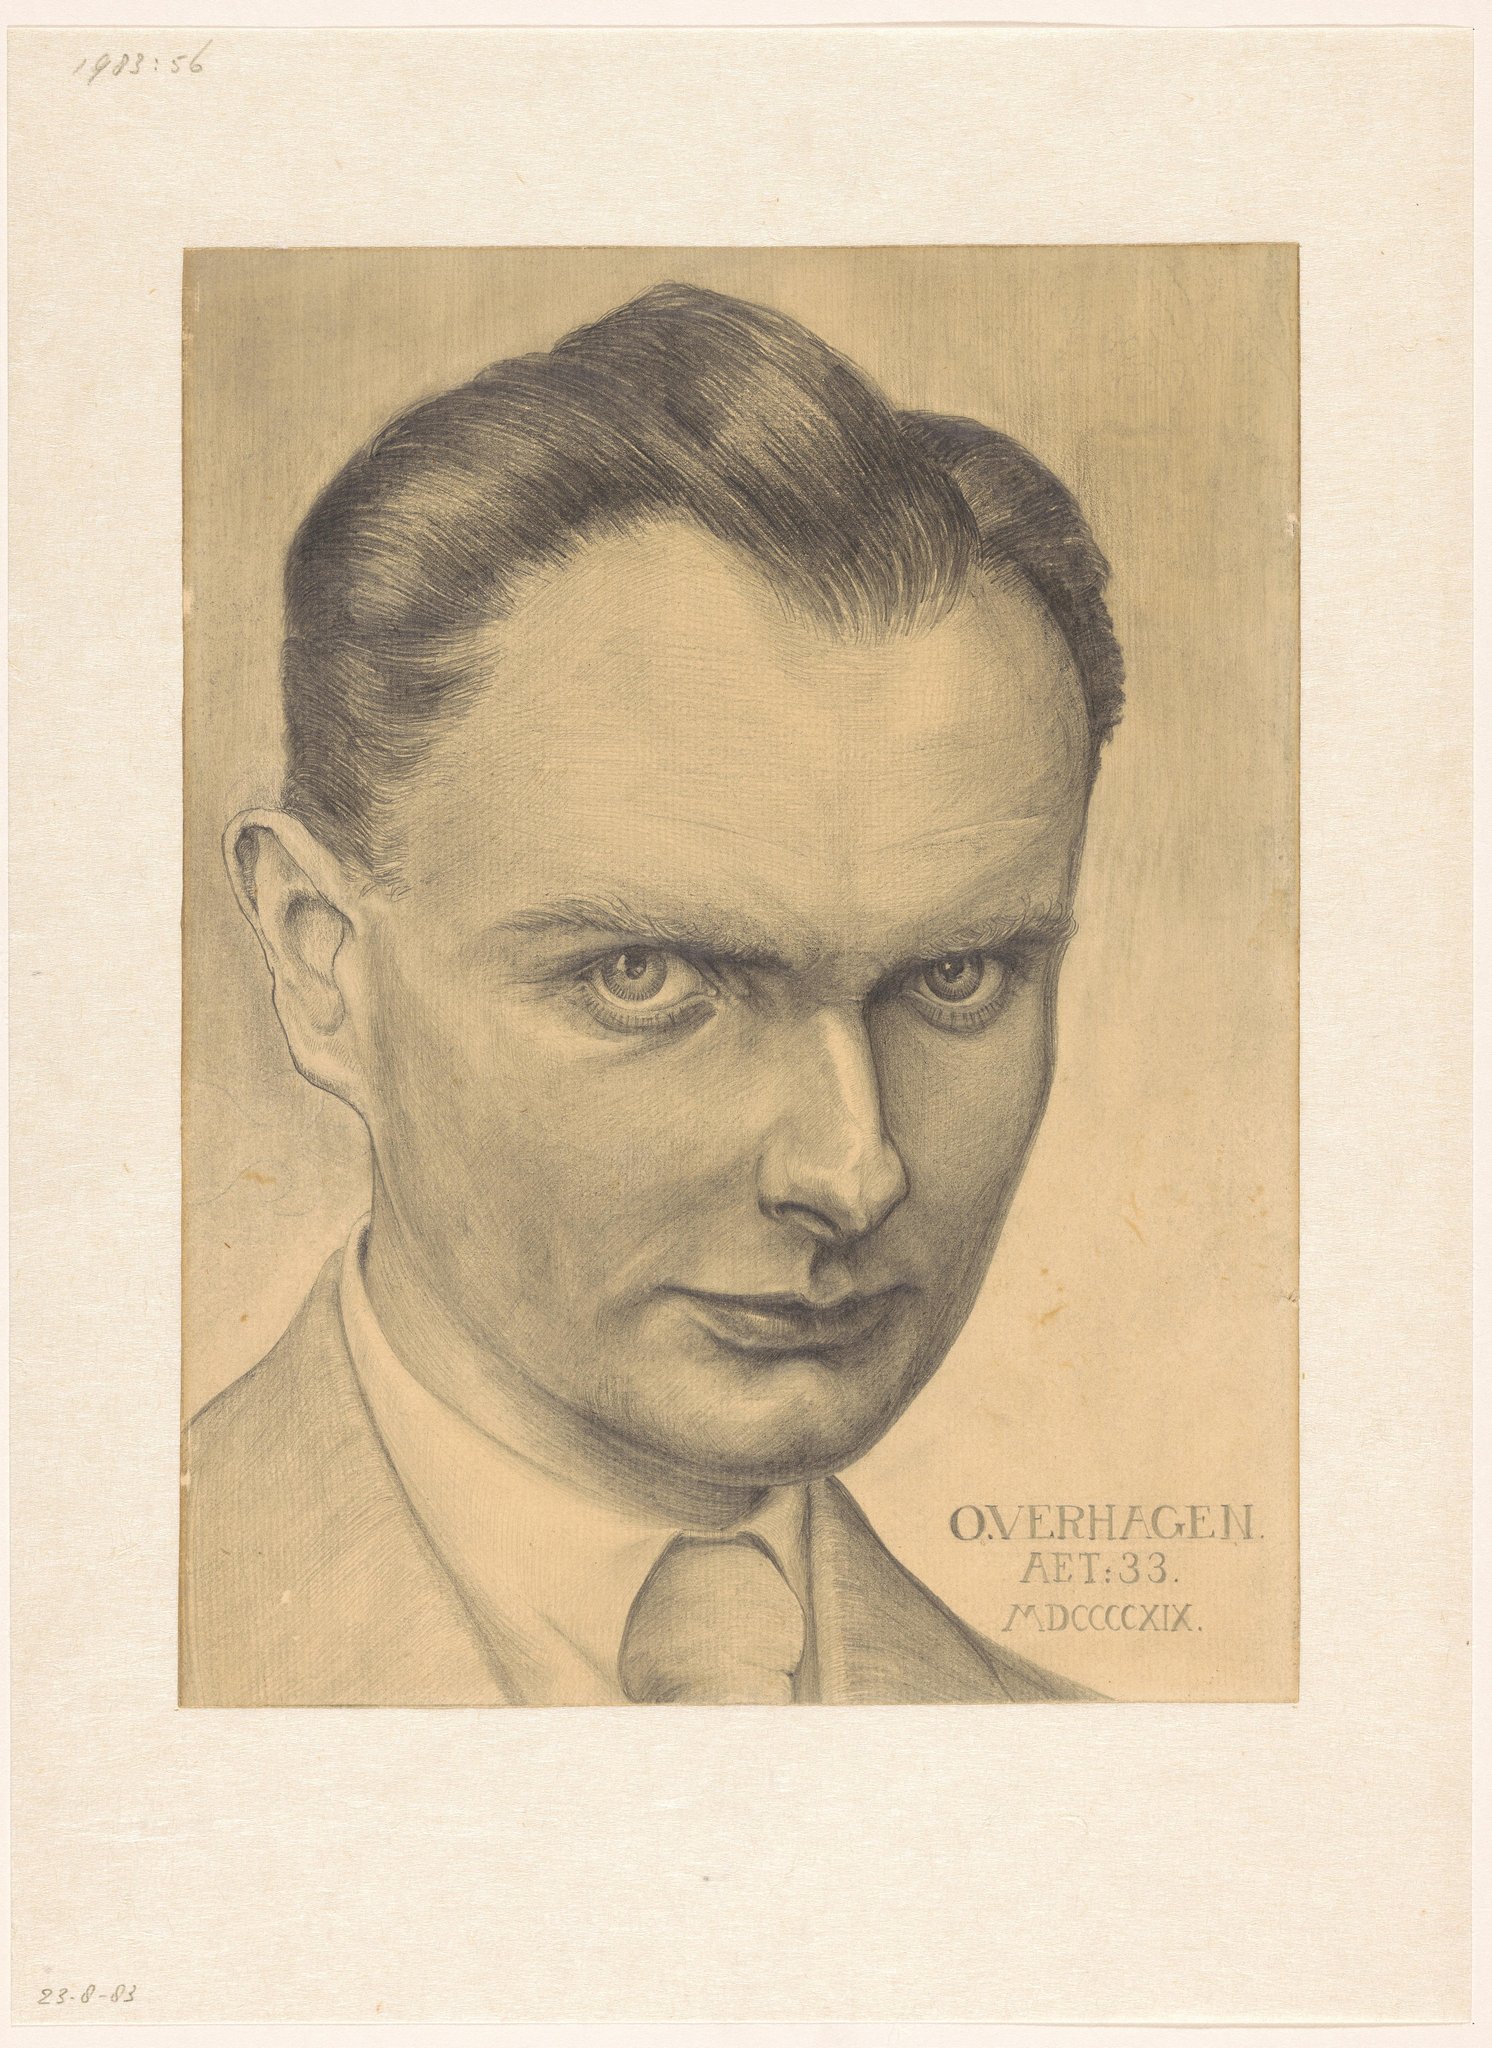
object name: drawing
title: Zelfportret op 33-jarige leeftijd.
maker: otto verhagen (i)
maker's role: draughtsman, print maker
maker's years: 1885-1951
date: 1919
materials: paper, pencil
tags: the hague, print maker, draughtsman, otto verhagen (i), historical persons, portrait, self-portrait of artist, portrait, self-portrait of draughtsman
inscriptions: collector's mark: Lugt 2228